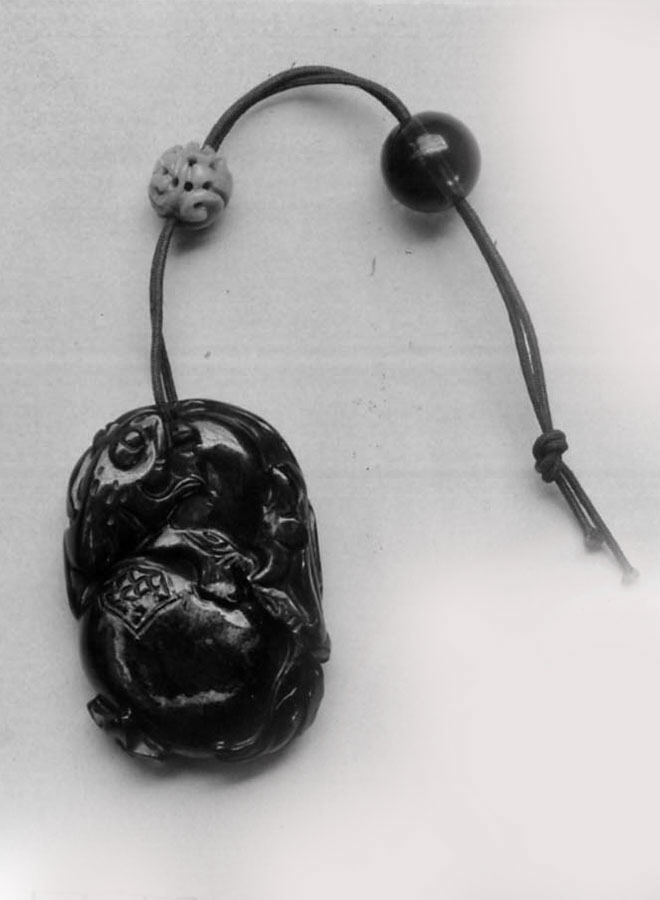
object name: pendant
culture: chinese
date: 1801-1900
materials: amber